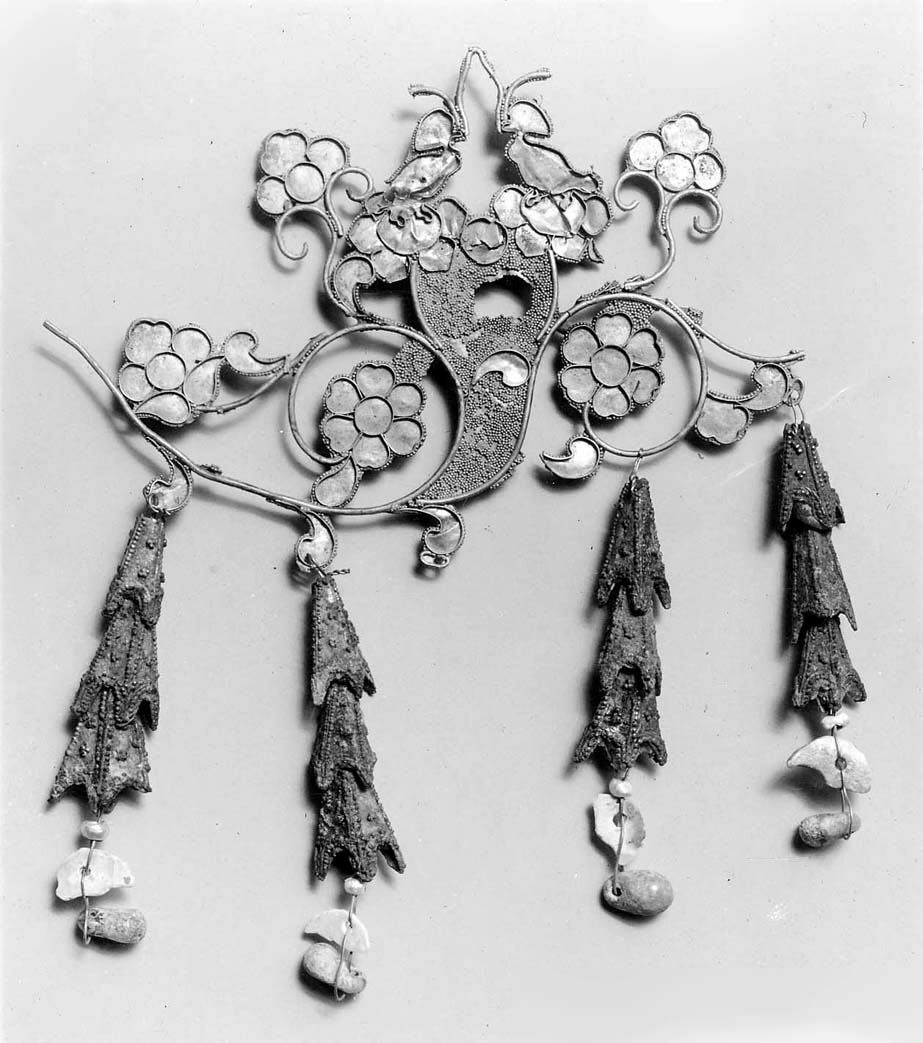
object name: ornament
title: Side Ornament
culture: chinese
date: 618-907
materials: gold